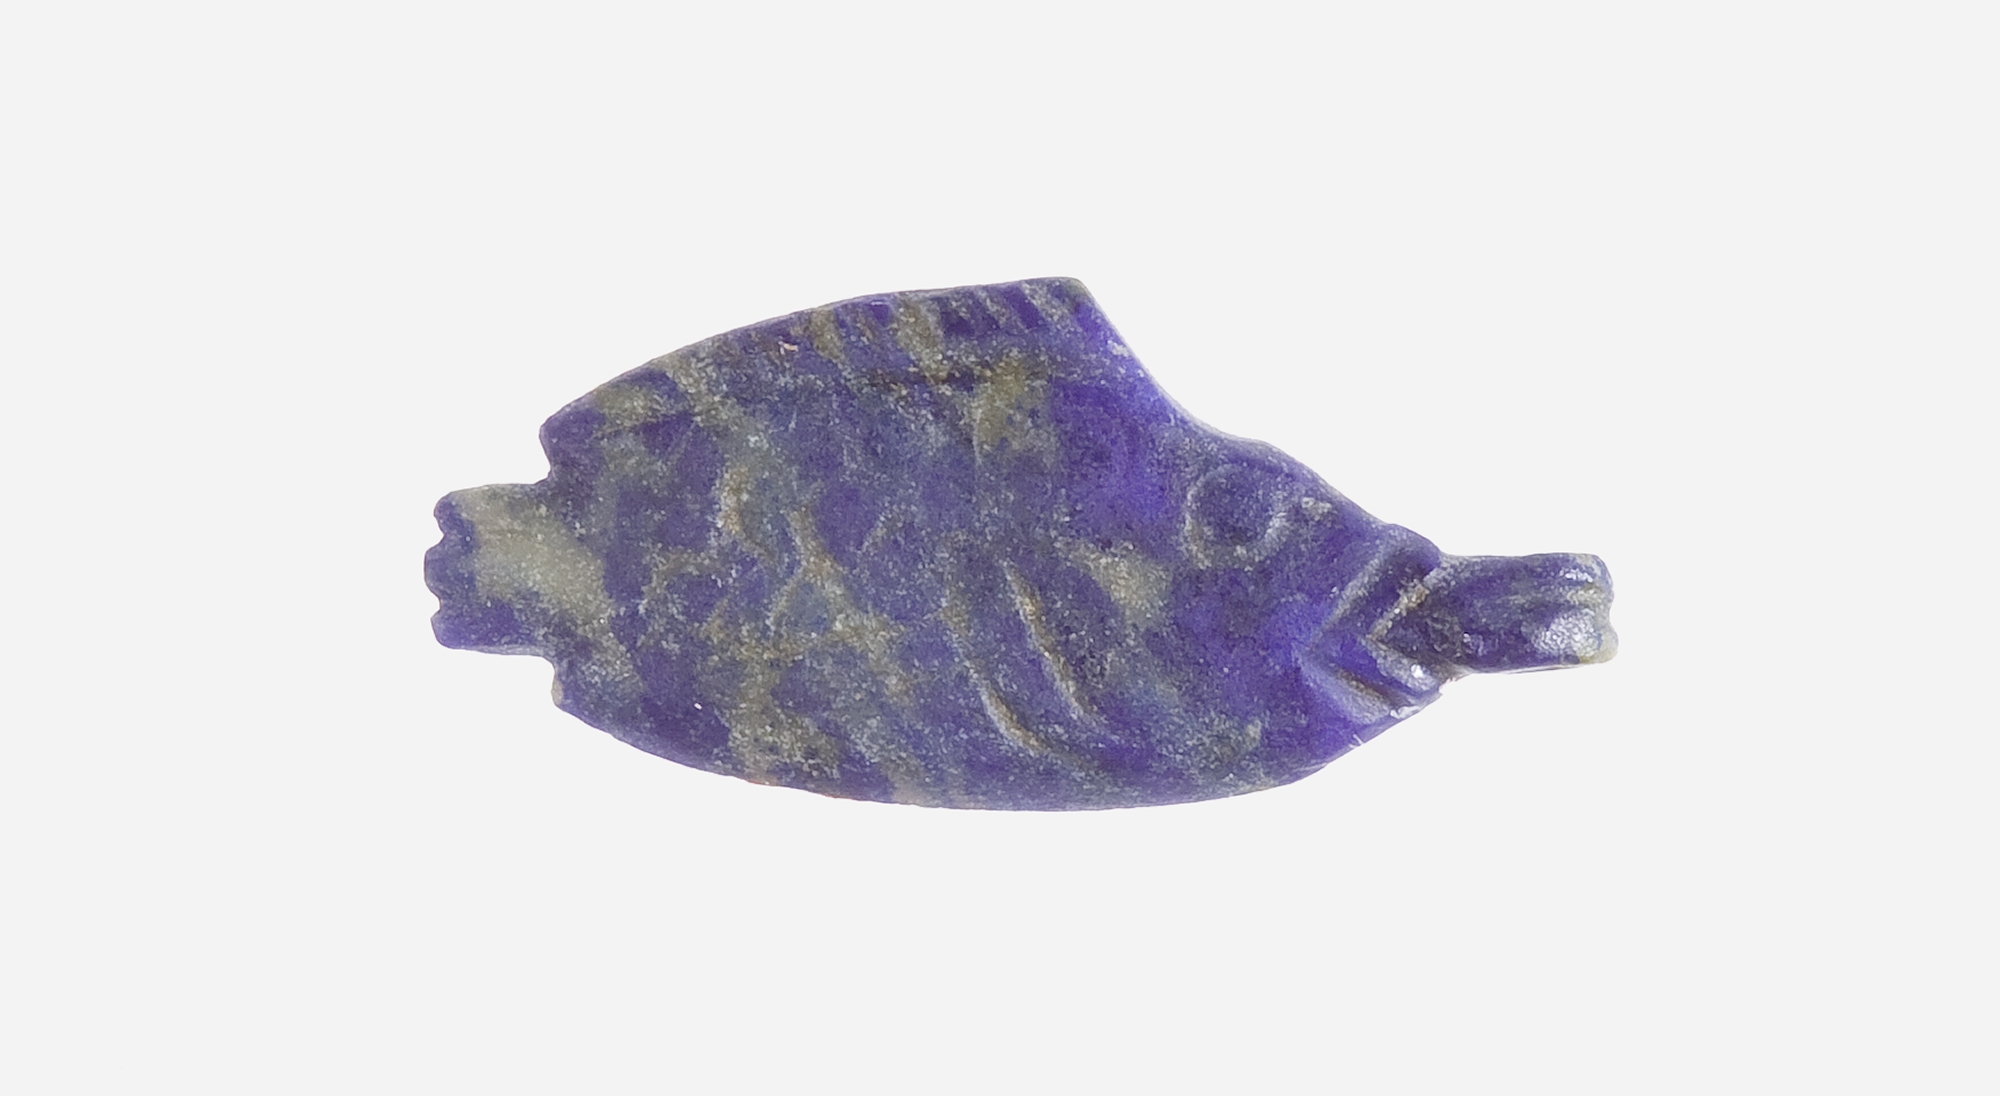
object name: amulet, fish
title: Fish amulet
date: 1550-1295 BCE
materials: lapis lazuli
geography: egypt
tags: fish